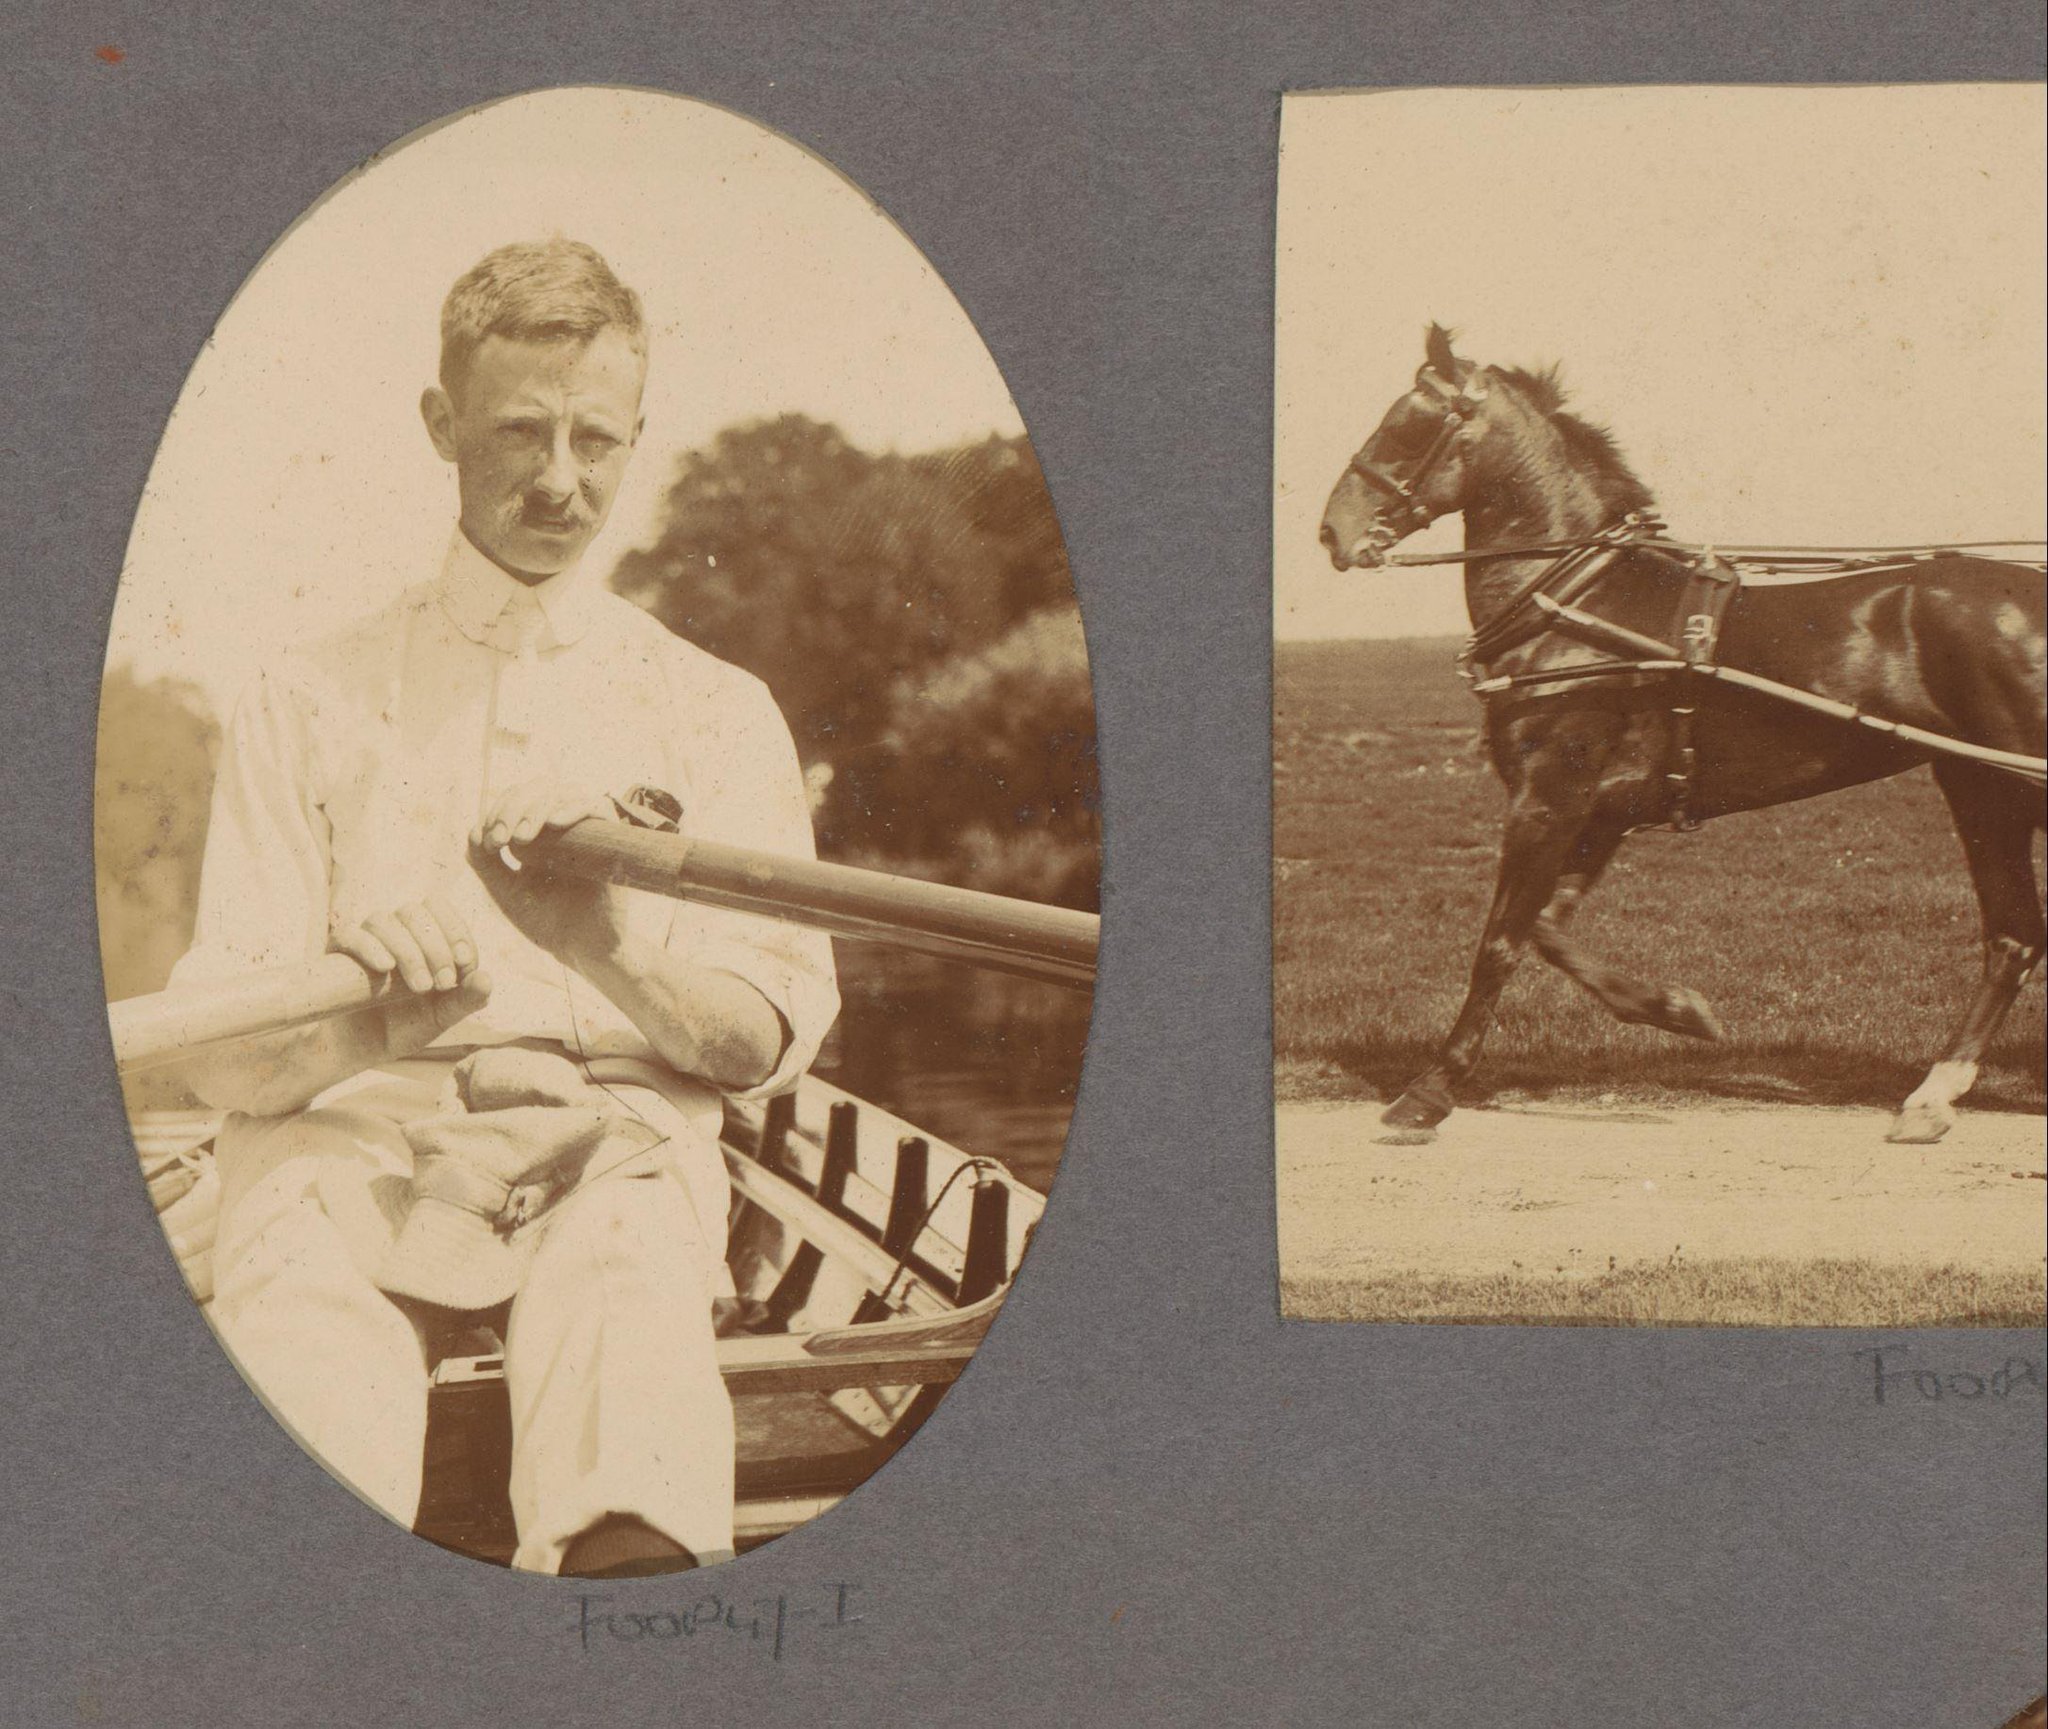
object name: photograph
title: Portret van een man in een roeiboot, vermoedelijk in Nederland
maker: Anonymous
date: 1902-1906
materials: cardboard, paper, photographic support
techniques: gelatin silver print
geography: netherlands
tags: adult man, rowing, canoeing, etc. (sport), netherlands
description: Onderdeel van Reisalbum van een Nederlandse familie met bezienswaardigheden in Europa, Egypte en New York.